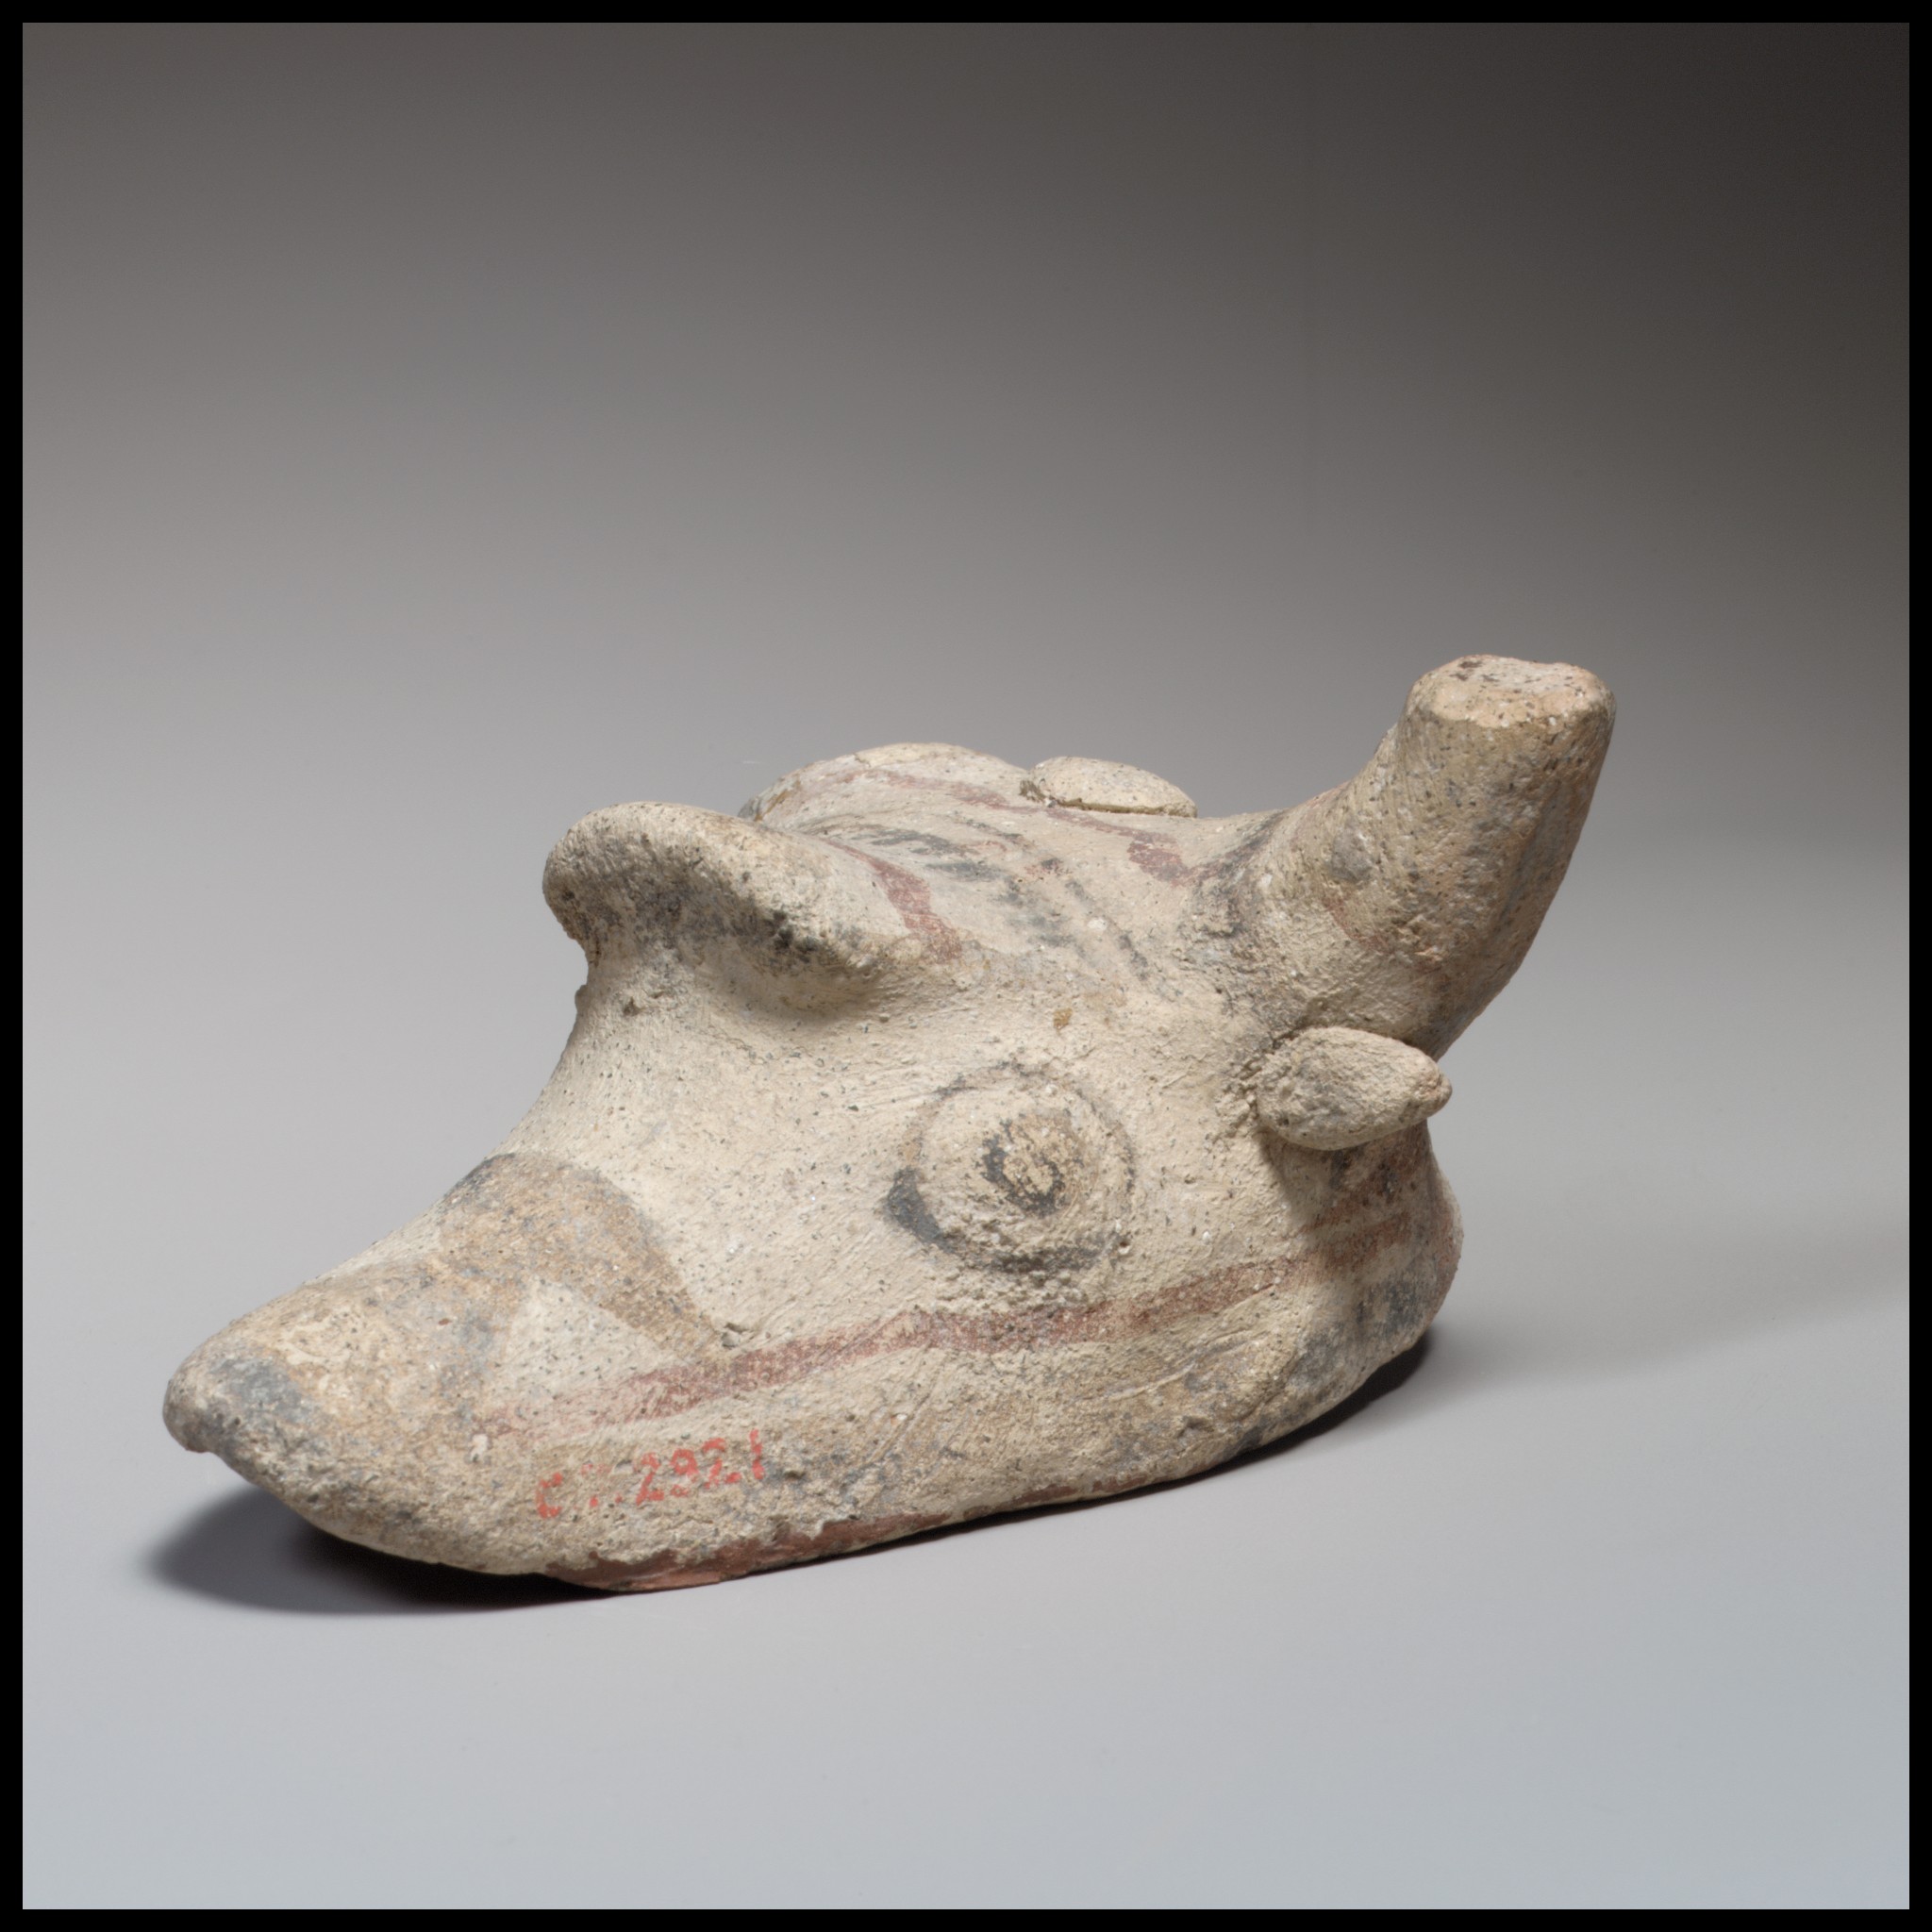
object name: mask of a bull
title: Bull's head mask with human characteristics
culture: cypriot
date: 600-480 BCE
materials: terracotta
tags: masks,bulls